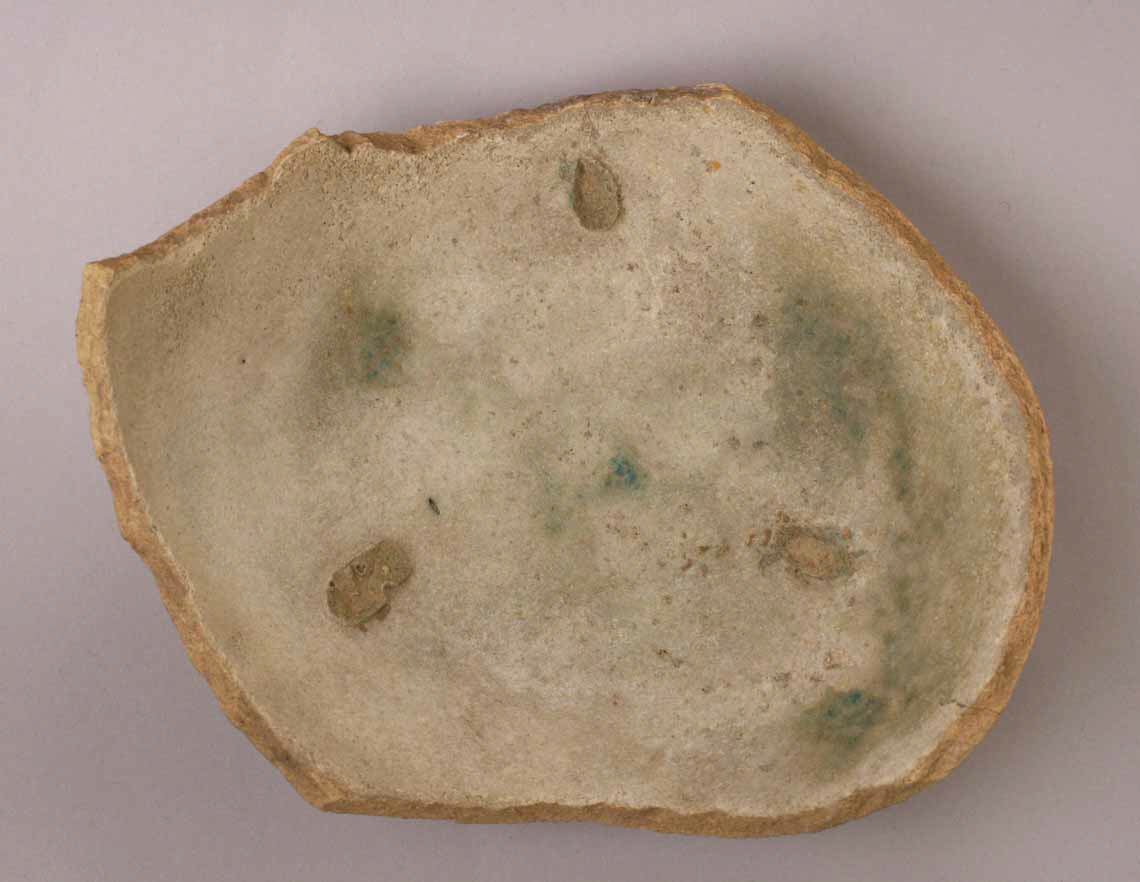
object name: fragment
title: Ceramic Fragment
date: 201-700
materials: earthenware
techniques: glazing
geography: iraq